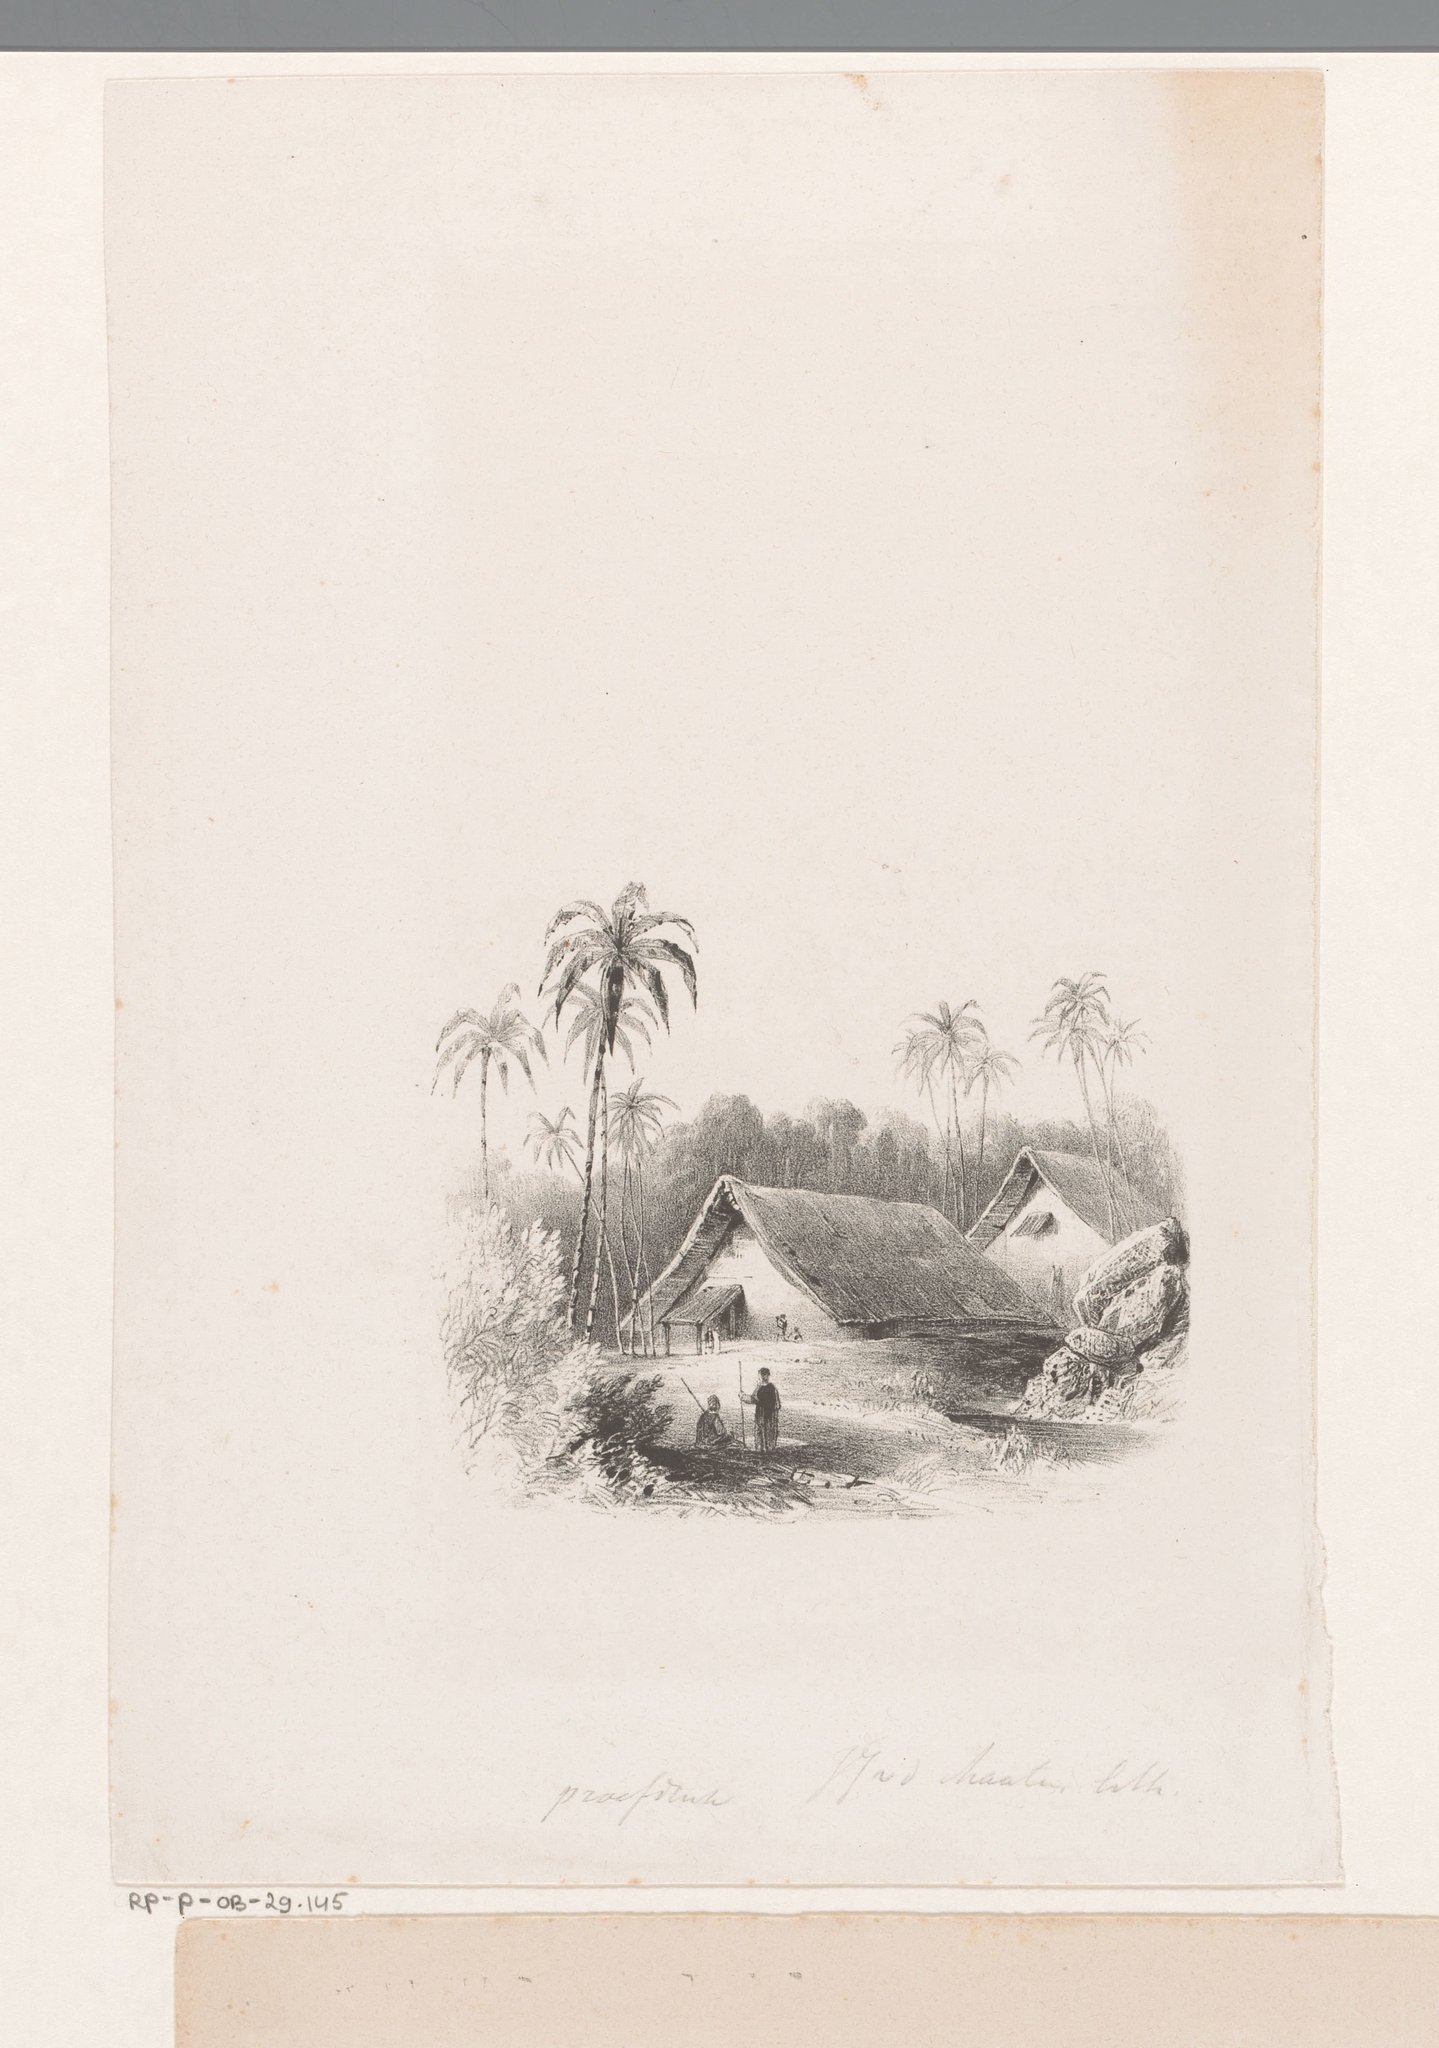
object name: print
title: Tropisch landschap met huizen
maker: jacob jan van der maaten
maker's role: draughtsman, print maker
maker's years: 1820-1879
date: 1830-1879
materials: paper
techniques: lithograph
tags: landscapes in tropical and sub-tropical regions, trees: palm-tree, farm or solitary house in landscape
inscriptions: inscription: ‘proefdruk J J v d Maaten lith’, collector's mark: Lugt 2228